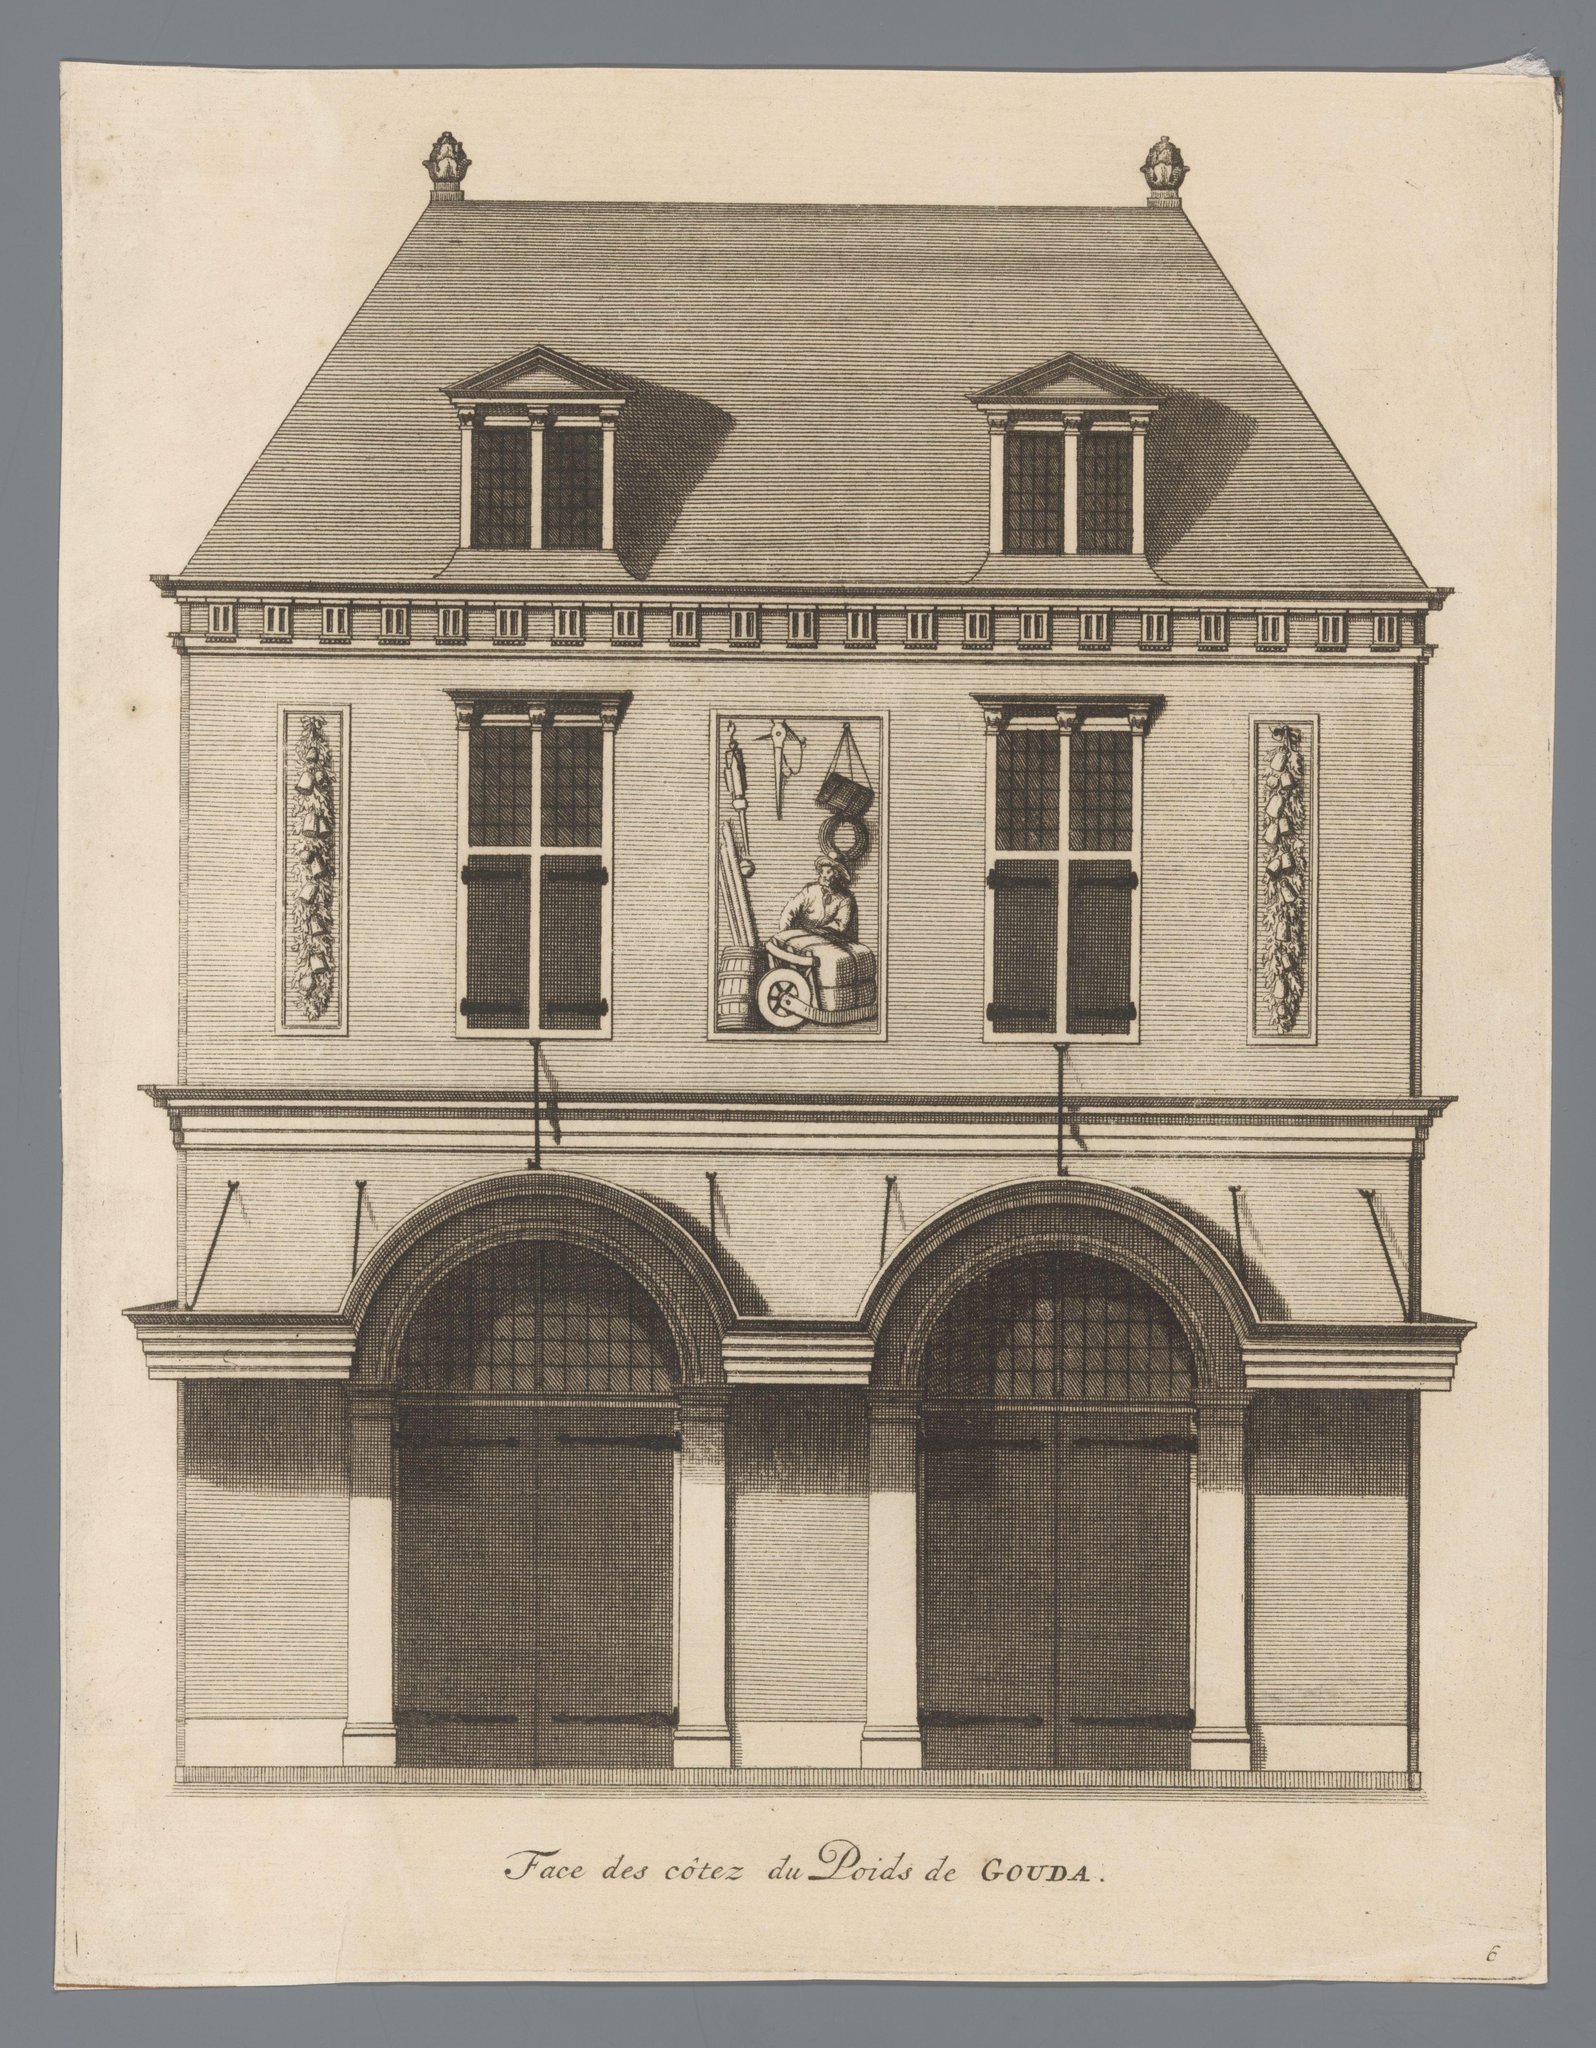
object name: book illustration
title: Gezicht op de zijgevel van de Waag te Gouda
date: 1715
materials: paper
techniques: etching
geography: leiden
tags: exterior ~ representation of a building, weigh-house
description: Prent uit: Les Ouvrages d'Architecture ordonnez par Pierre Post (...). Leiden: Pieter van der Aa, 1705.